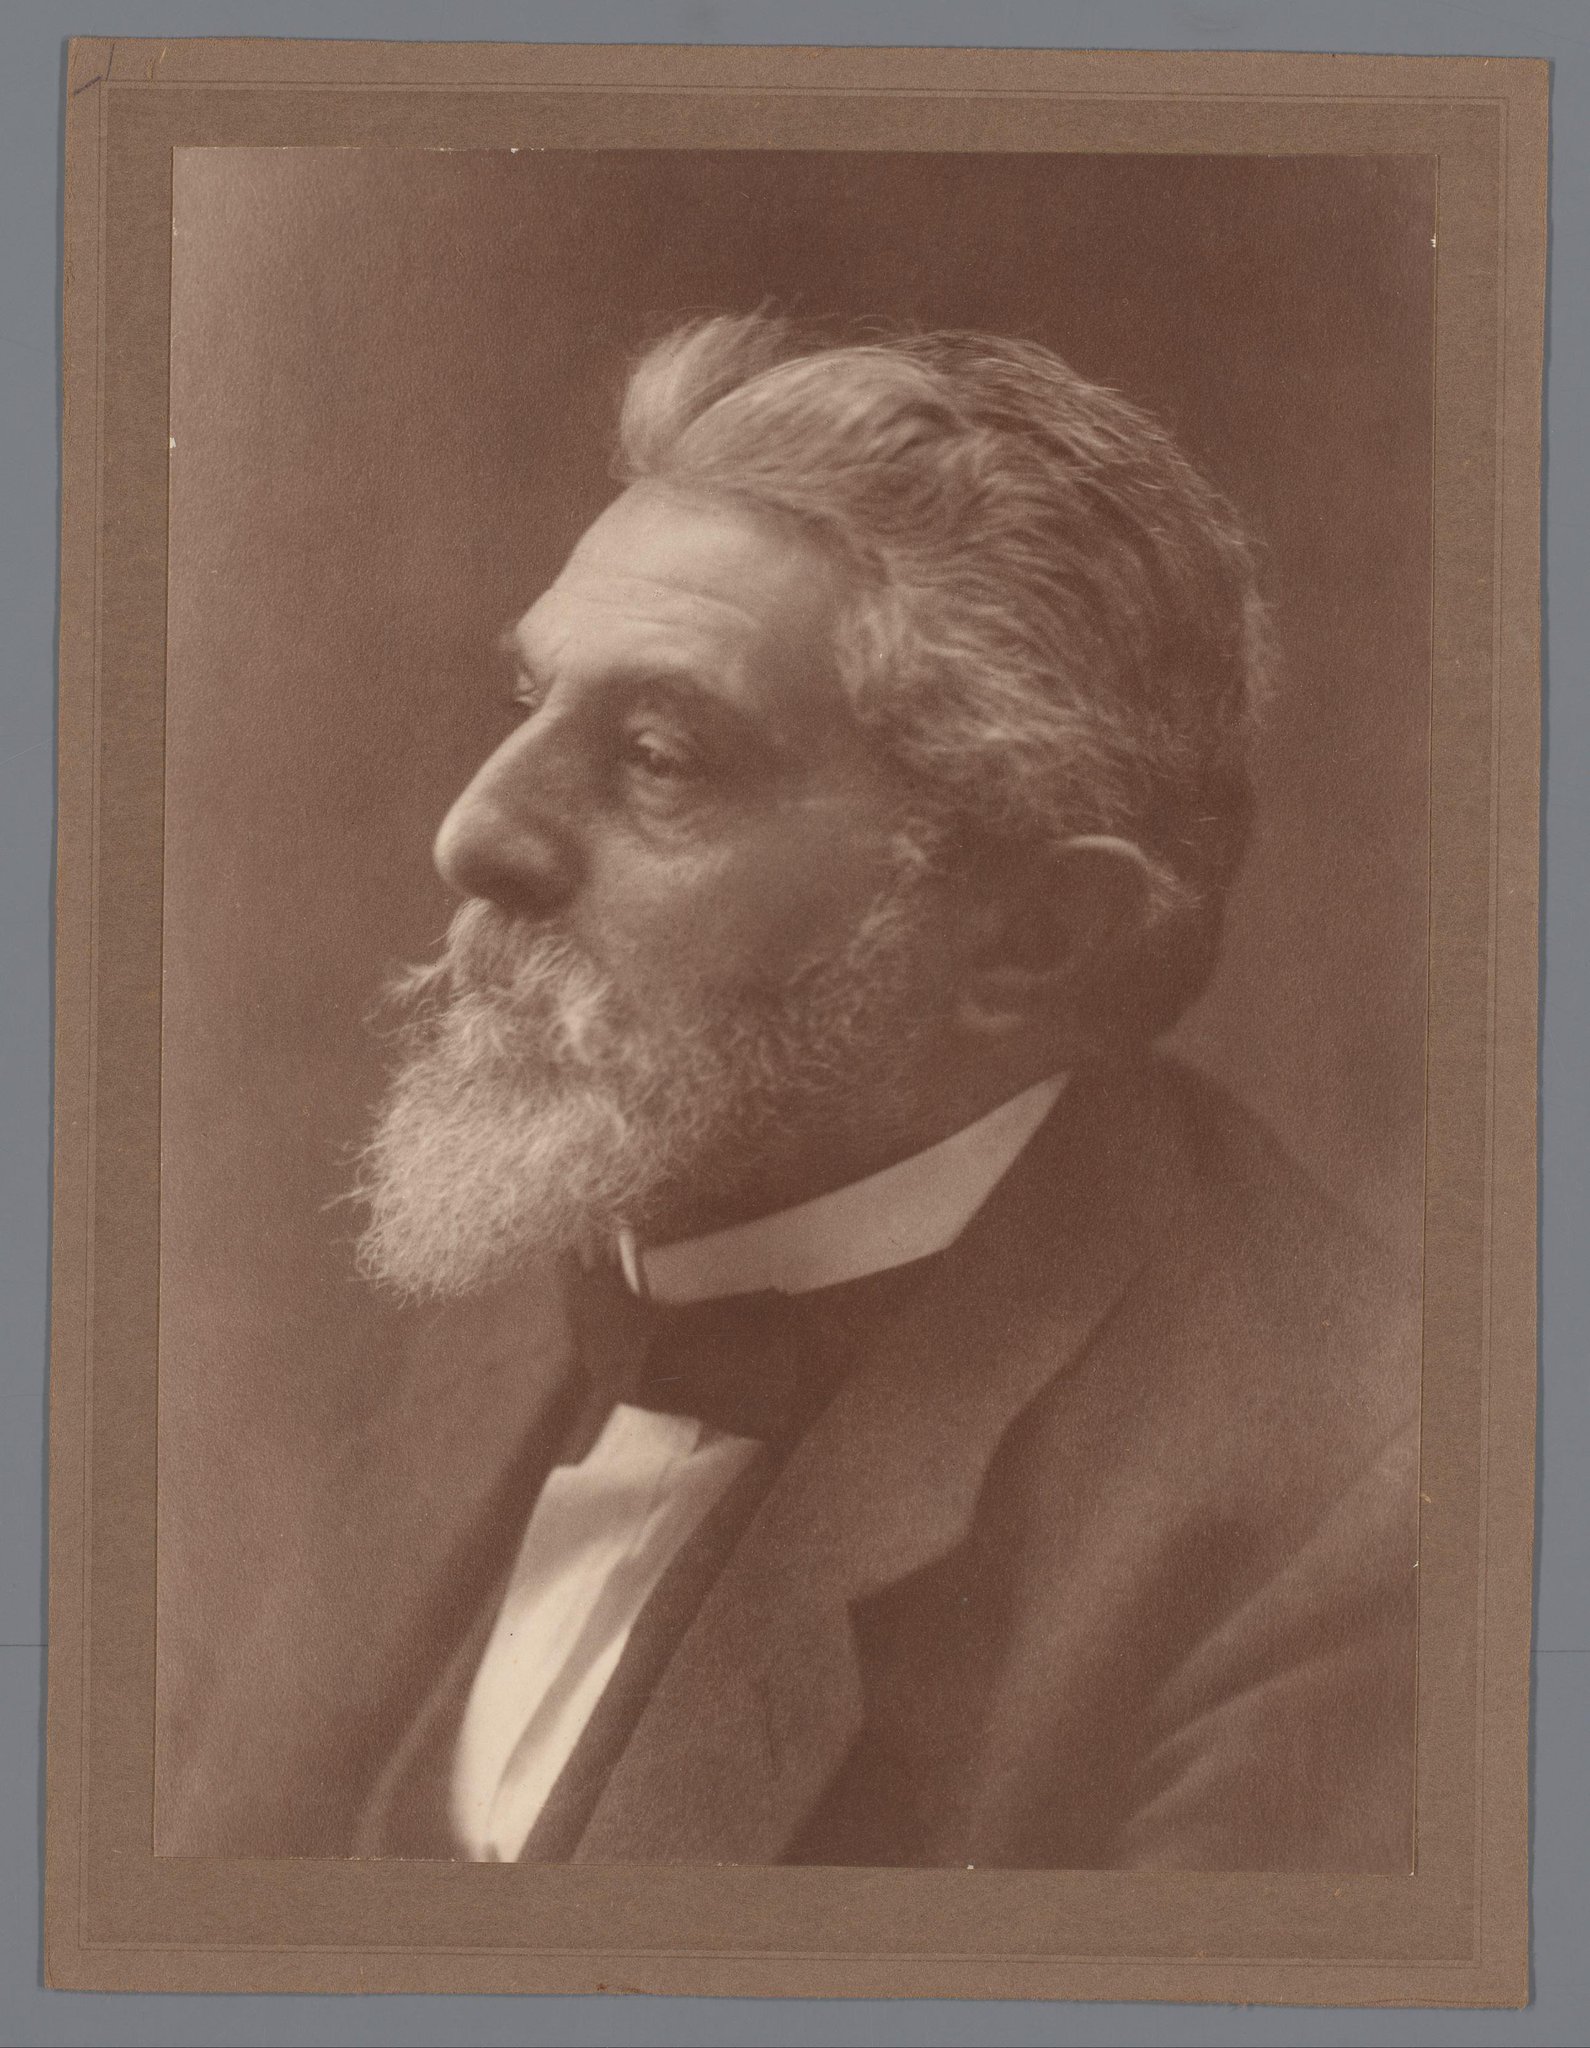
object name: photograph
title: Portret van een man in profiel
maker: Anonymous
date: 1885-1915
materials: cardboard, paper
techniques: gelatin silver print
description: Portret van een man in profiel, met grijze baard en pak.